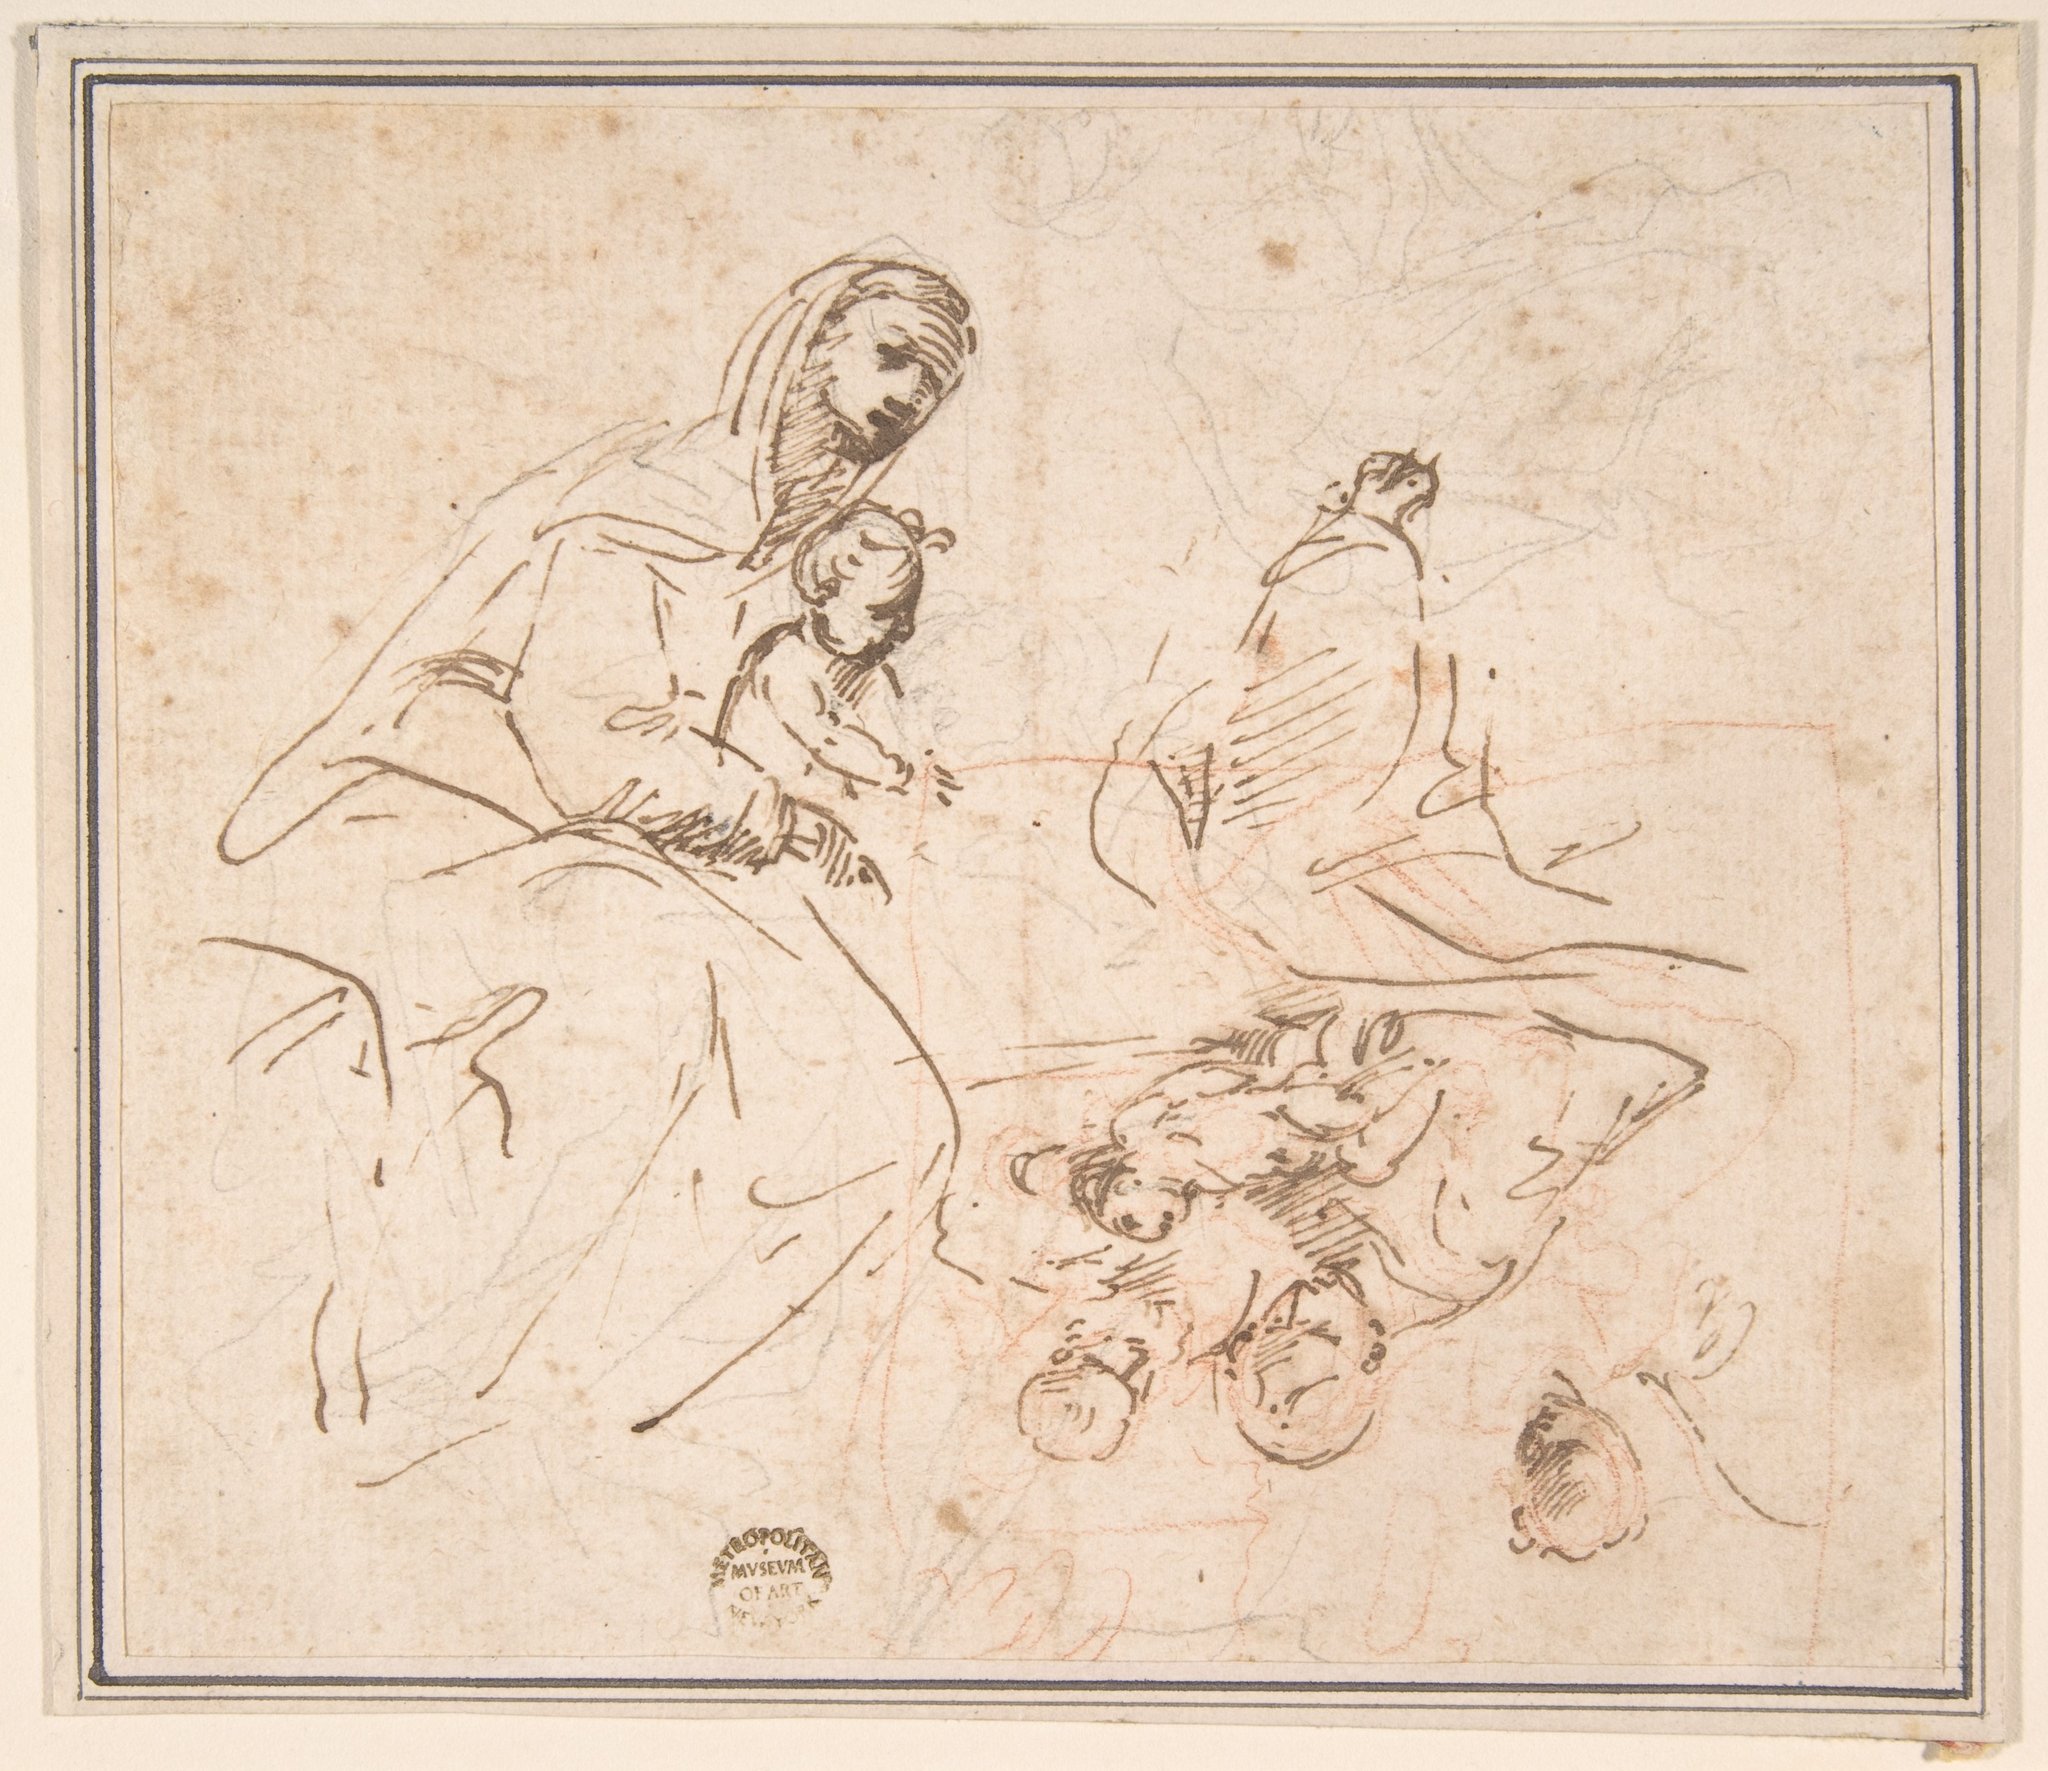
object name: drawing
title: Two Studies for the Madonna and Child (recto); Flagellation (verso)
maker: anonymous, italian, 16th century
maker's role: artist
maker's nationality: italian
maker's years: 1550-1600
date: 1501-1600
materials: ink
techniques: pen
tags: human figures,madonna and child